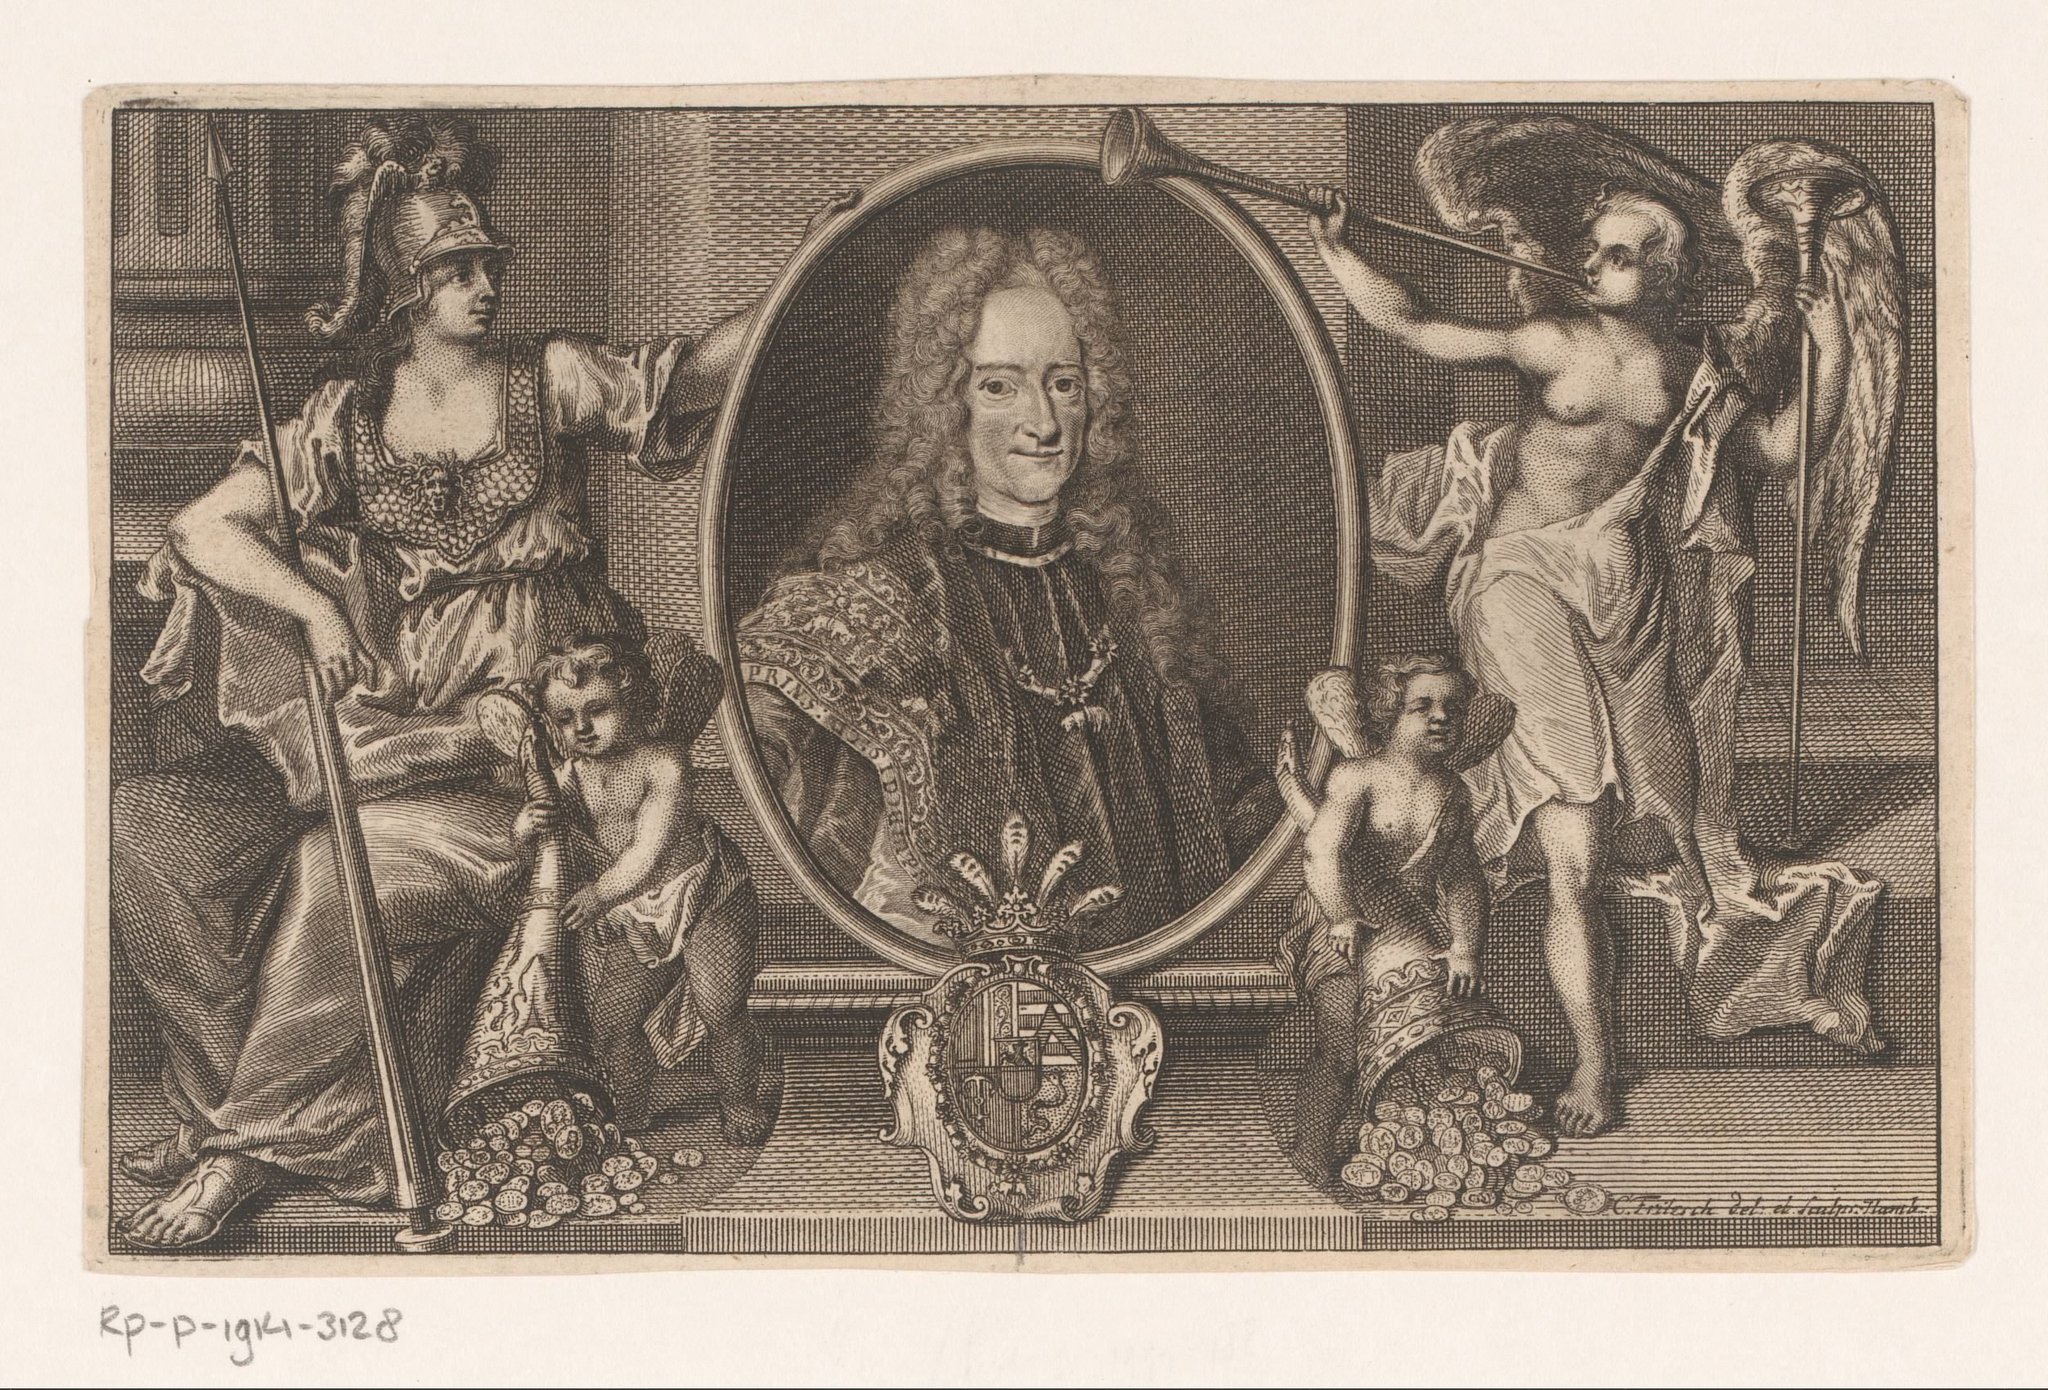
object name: print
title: Portret van Gundaker Thomas von Starhemberg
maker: christian fritzsch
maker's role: print maker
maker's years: 1695-1769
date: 1705-1745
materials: paper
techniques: engraving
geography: hamburg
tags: prague, 'cornucopia', horn of plenty (+ variant), (story of) minerva (pallas, athena), horn, trumpet, cornet, trombone, tuba, ornament ~ medallion, historical persons, knighthood order of the golden fleece - insignia of a knighthood order, e.g.: badge, chain (with name of order), angels, armorial bearing, heraldry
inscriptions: collector's mark: Lugt 2228